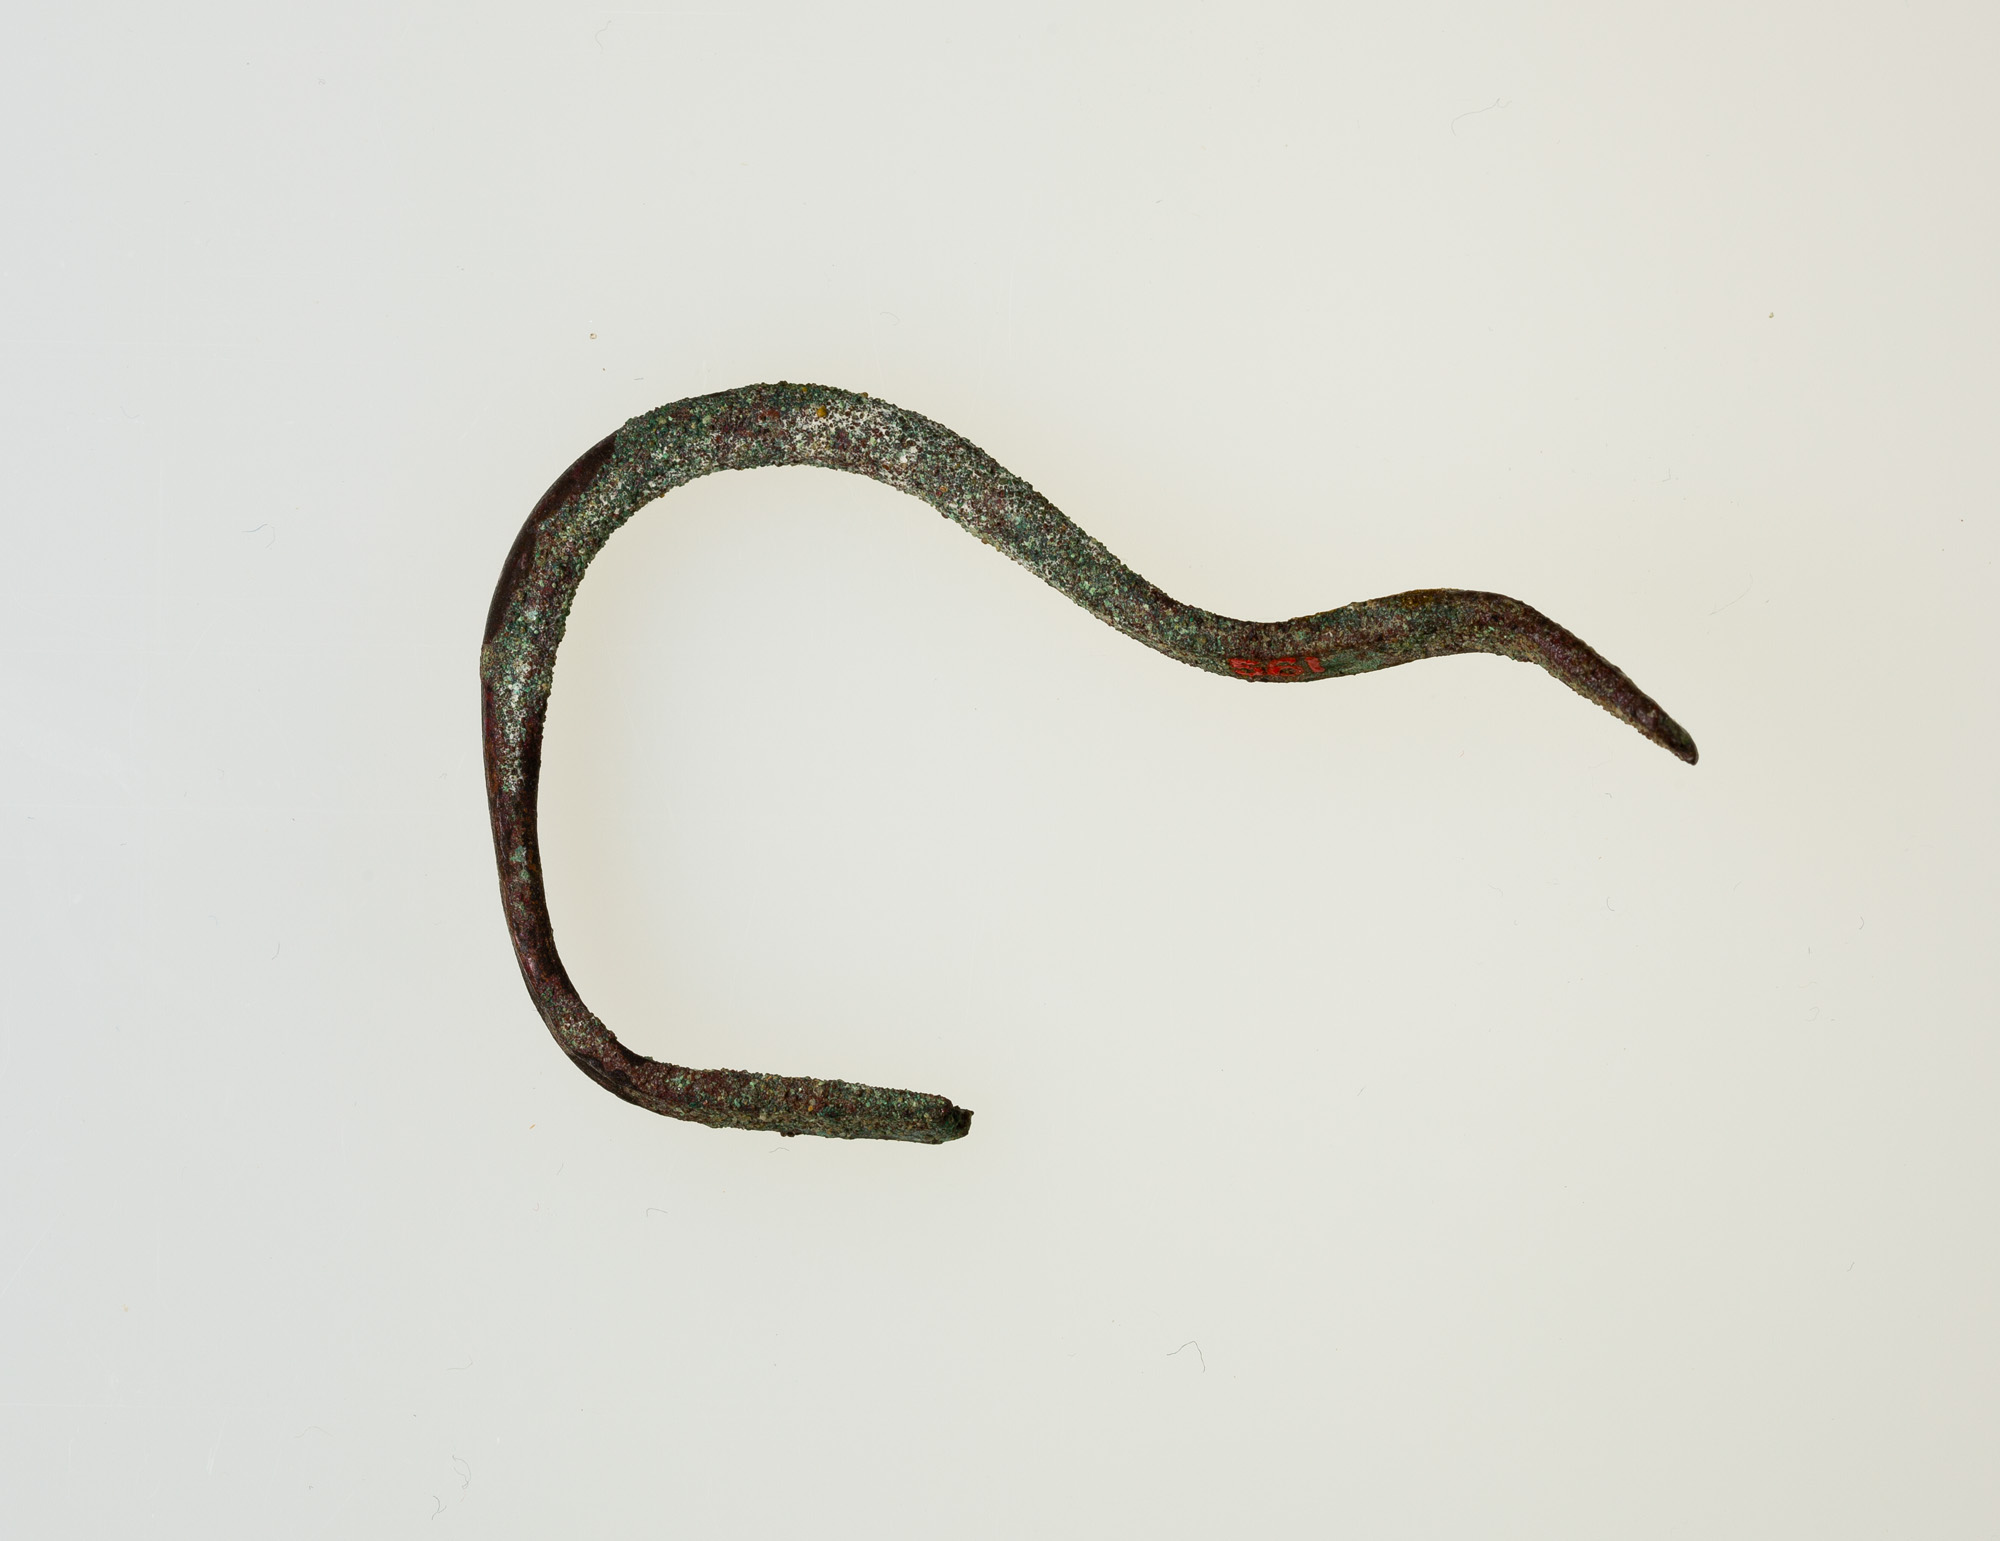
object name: jar, hook handle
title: Jar handle in form of a hook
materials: copper alloy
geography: egypt